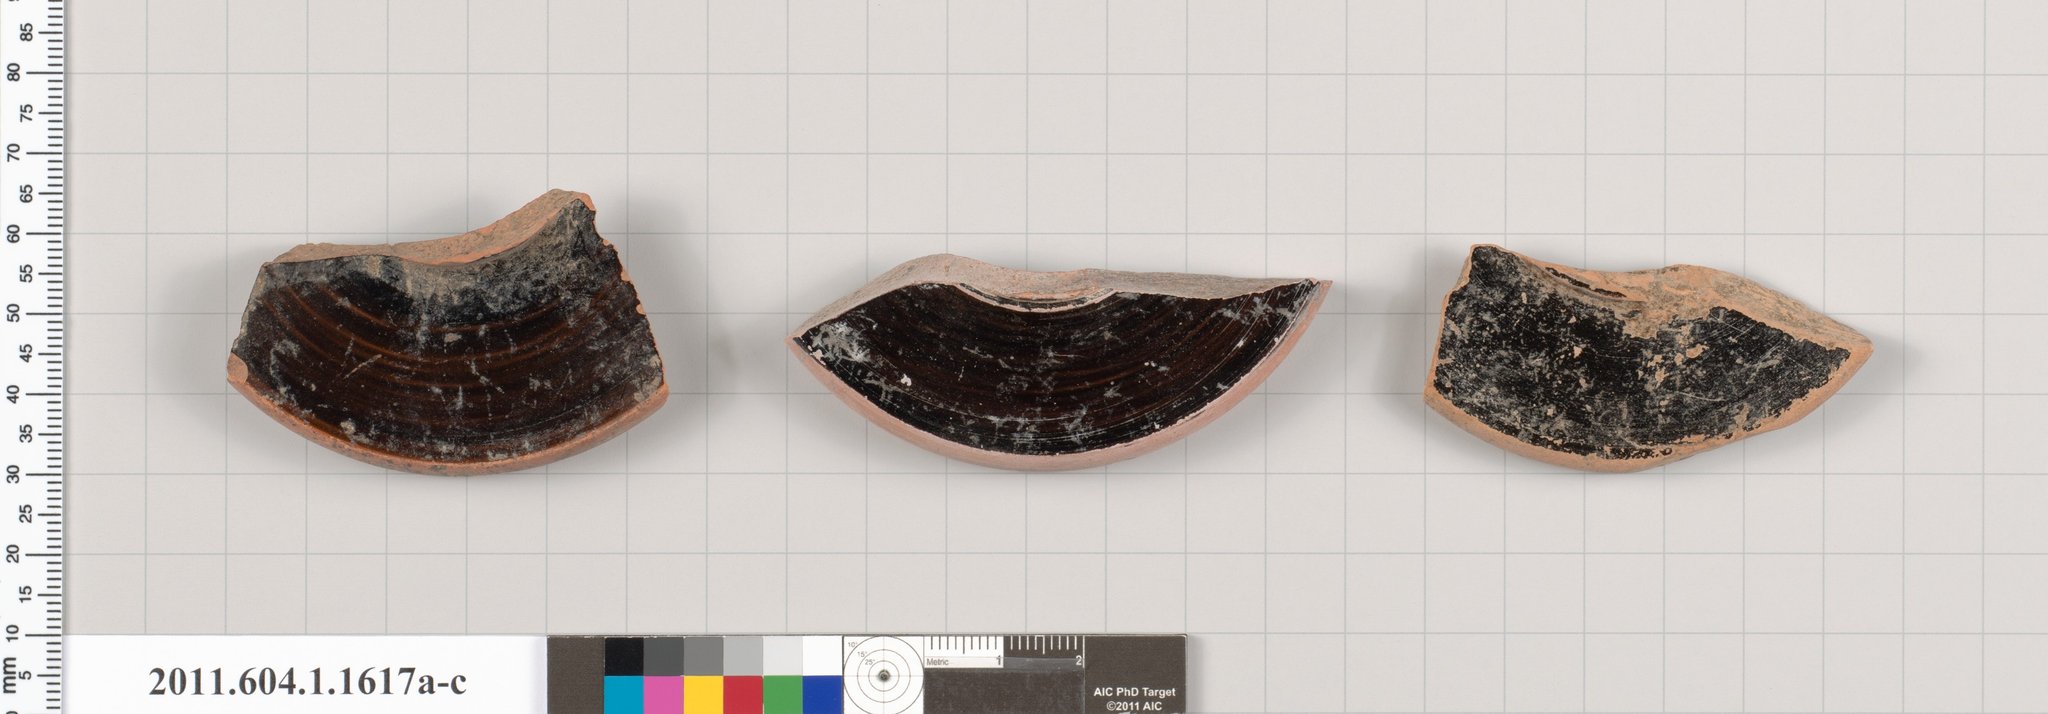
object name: kylix fragment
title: Terracotta fragments of kylikes (drinking cups)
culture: greek, attic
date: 500-401 BCE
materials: terracotta